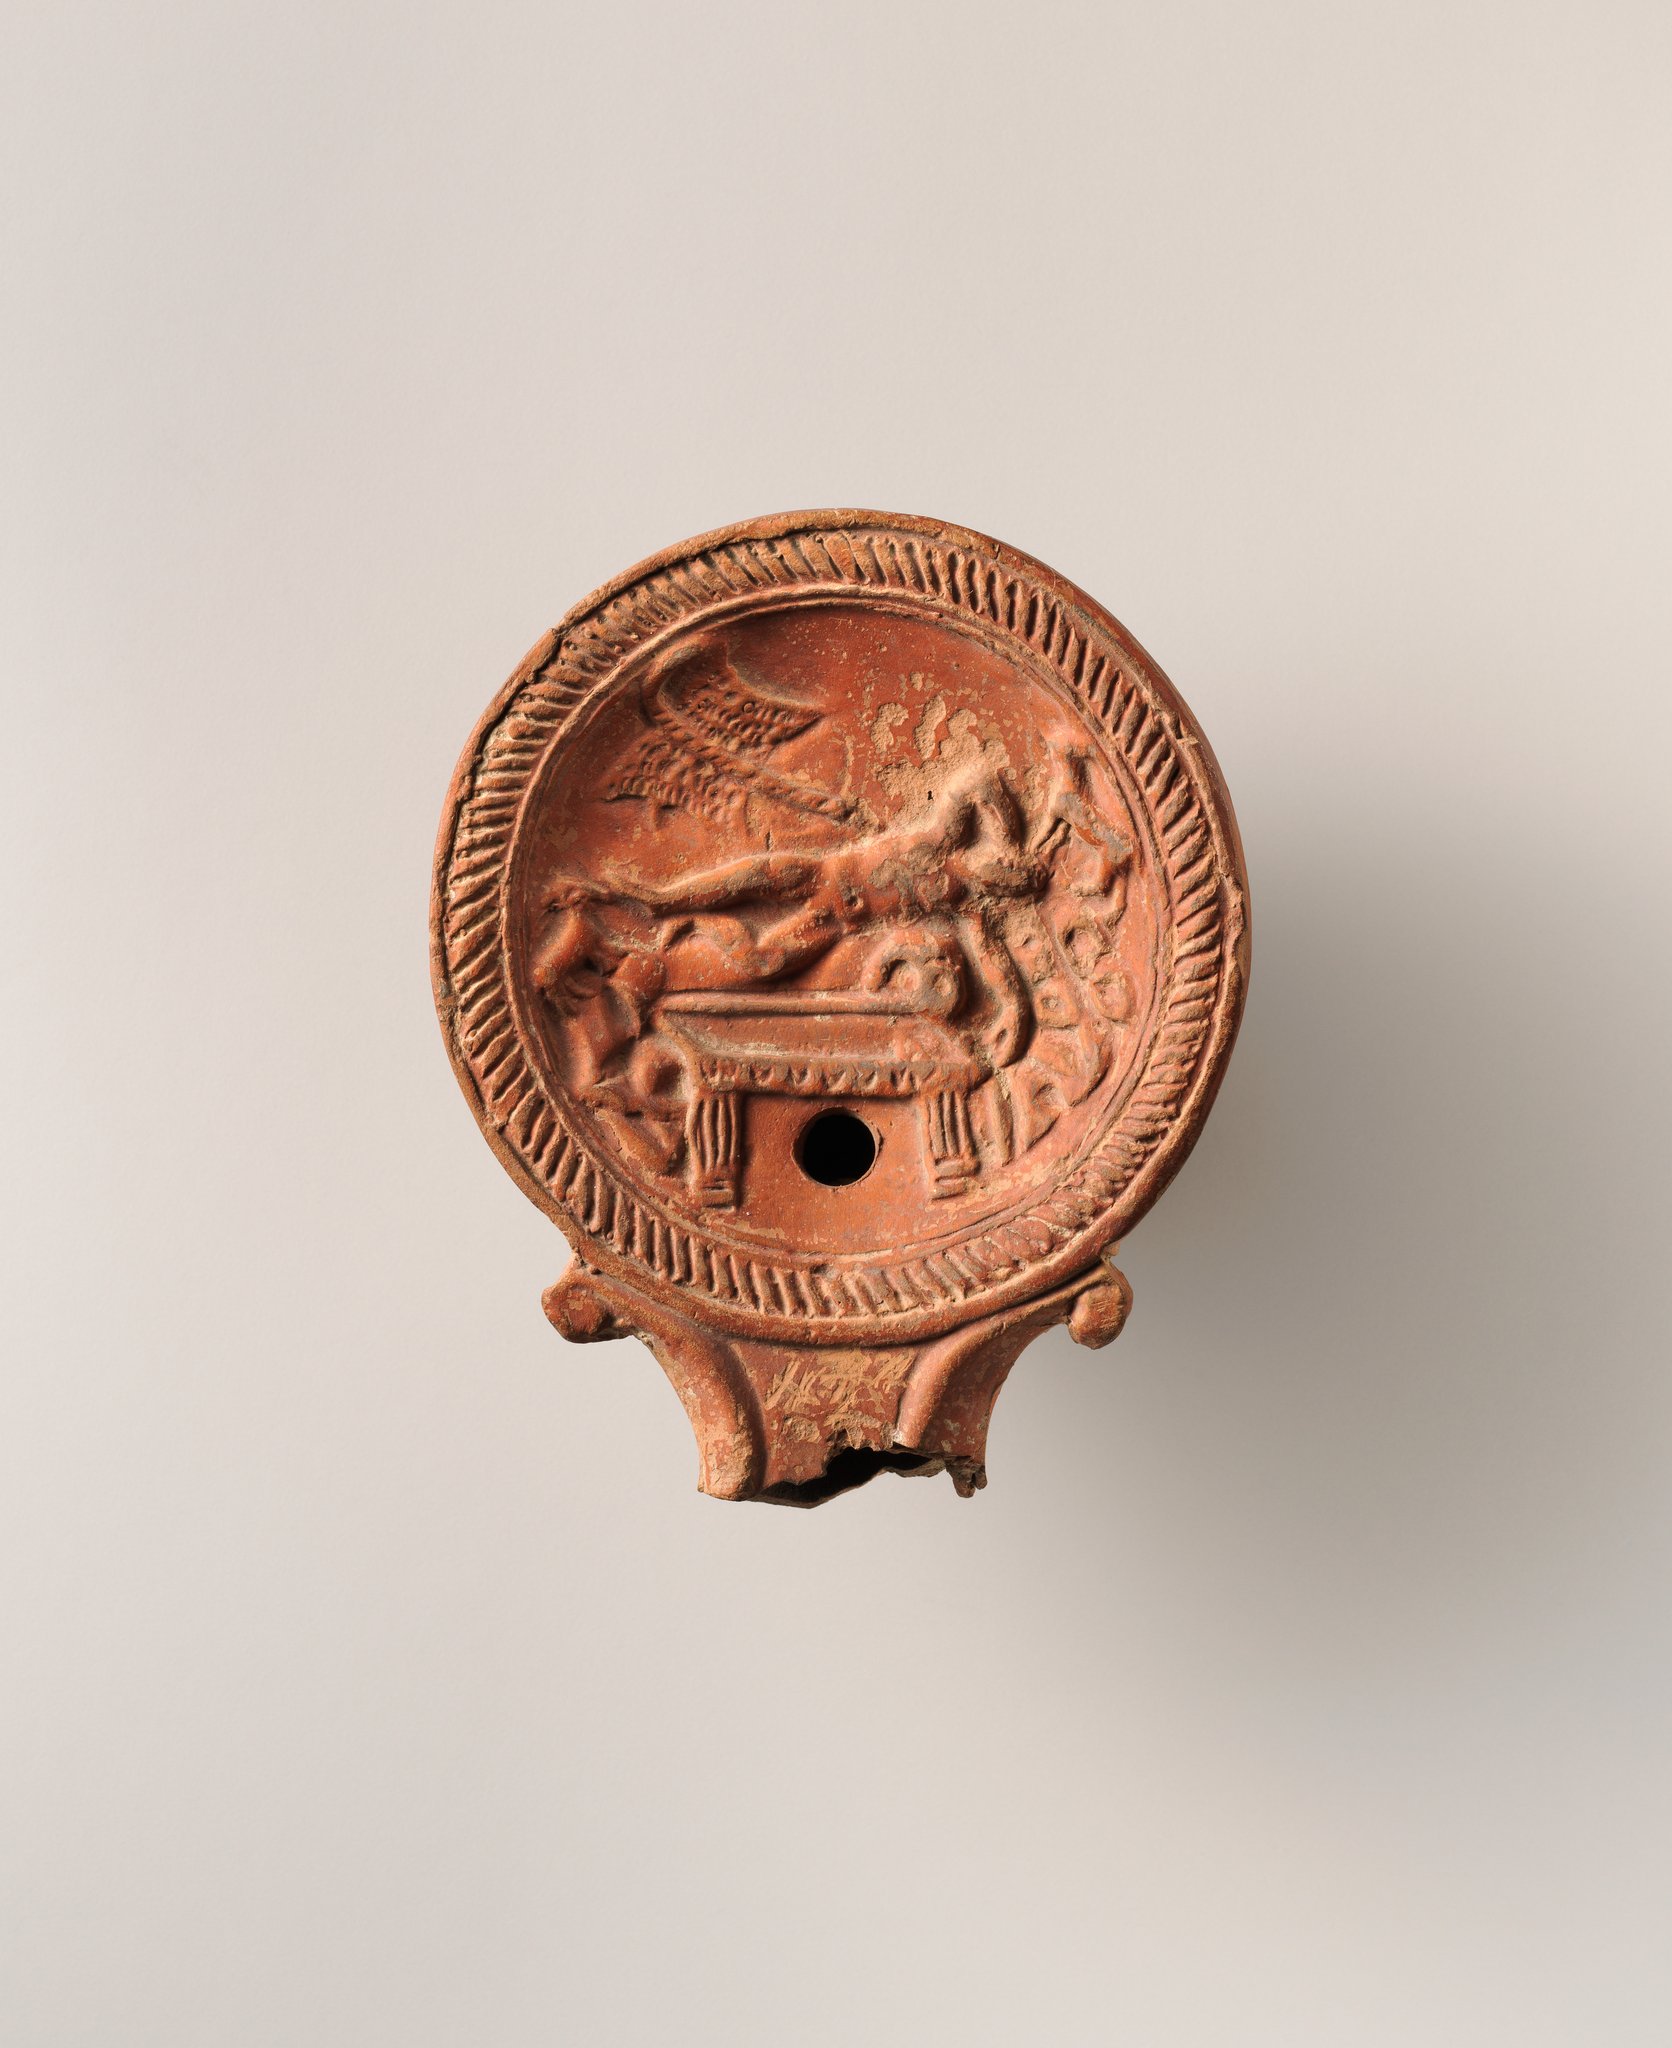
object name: lamp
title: Terracotta oil lamp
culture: roman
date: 670 BCE-330 CE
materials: terracotta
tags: male nudes,goats